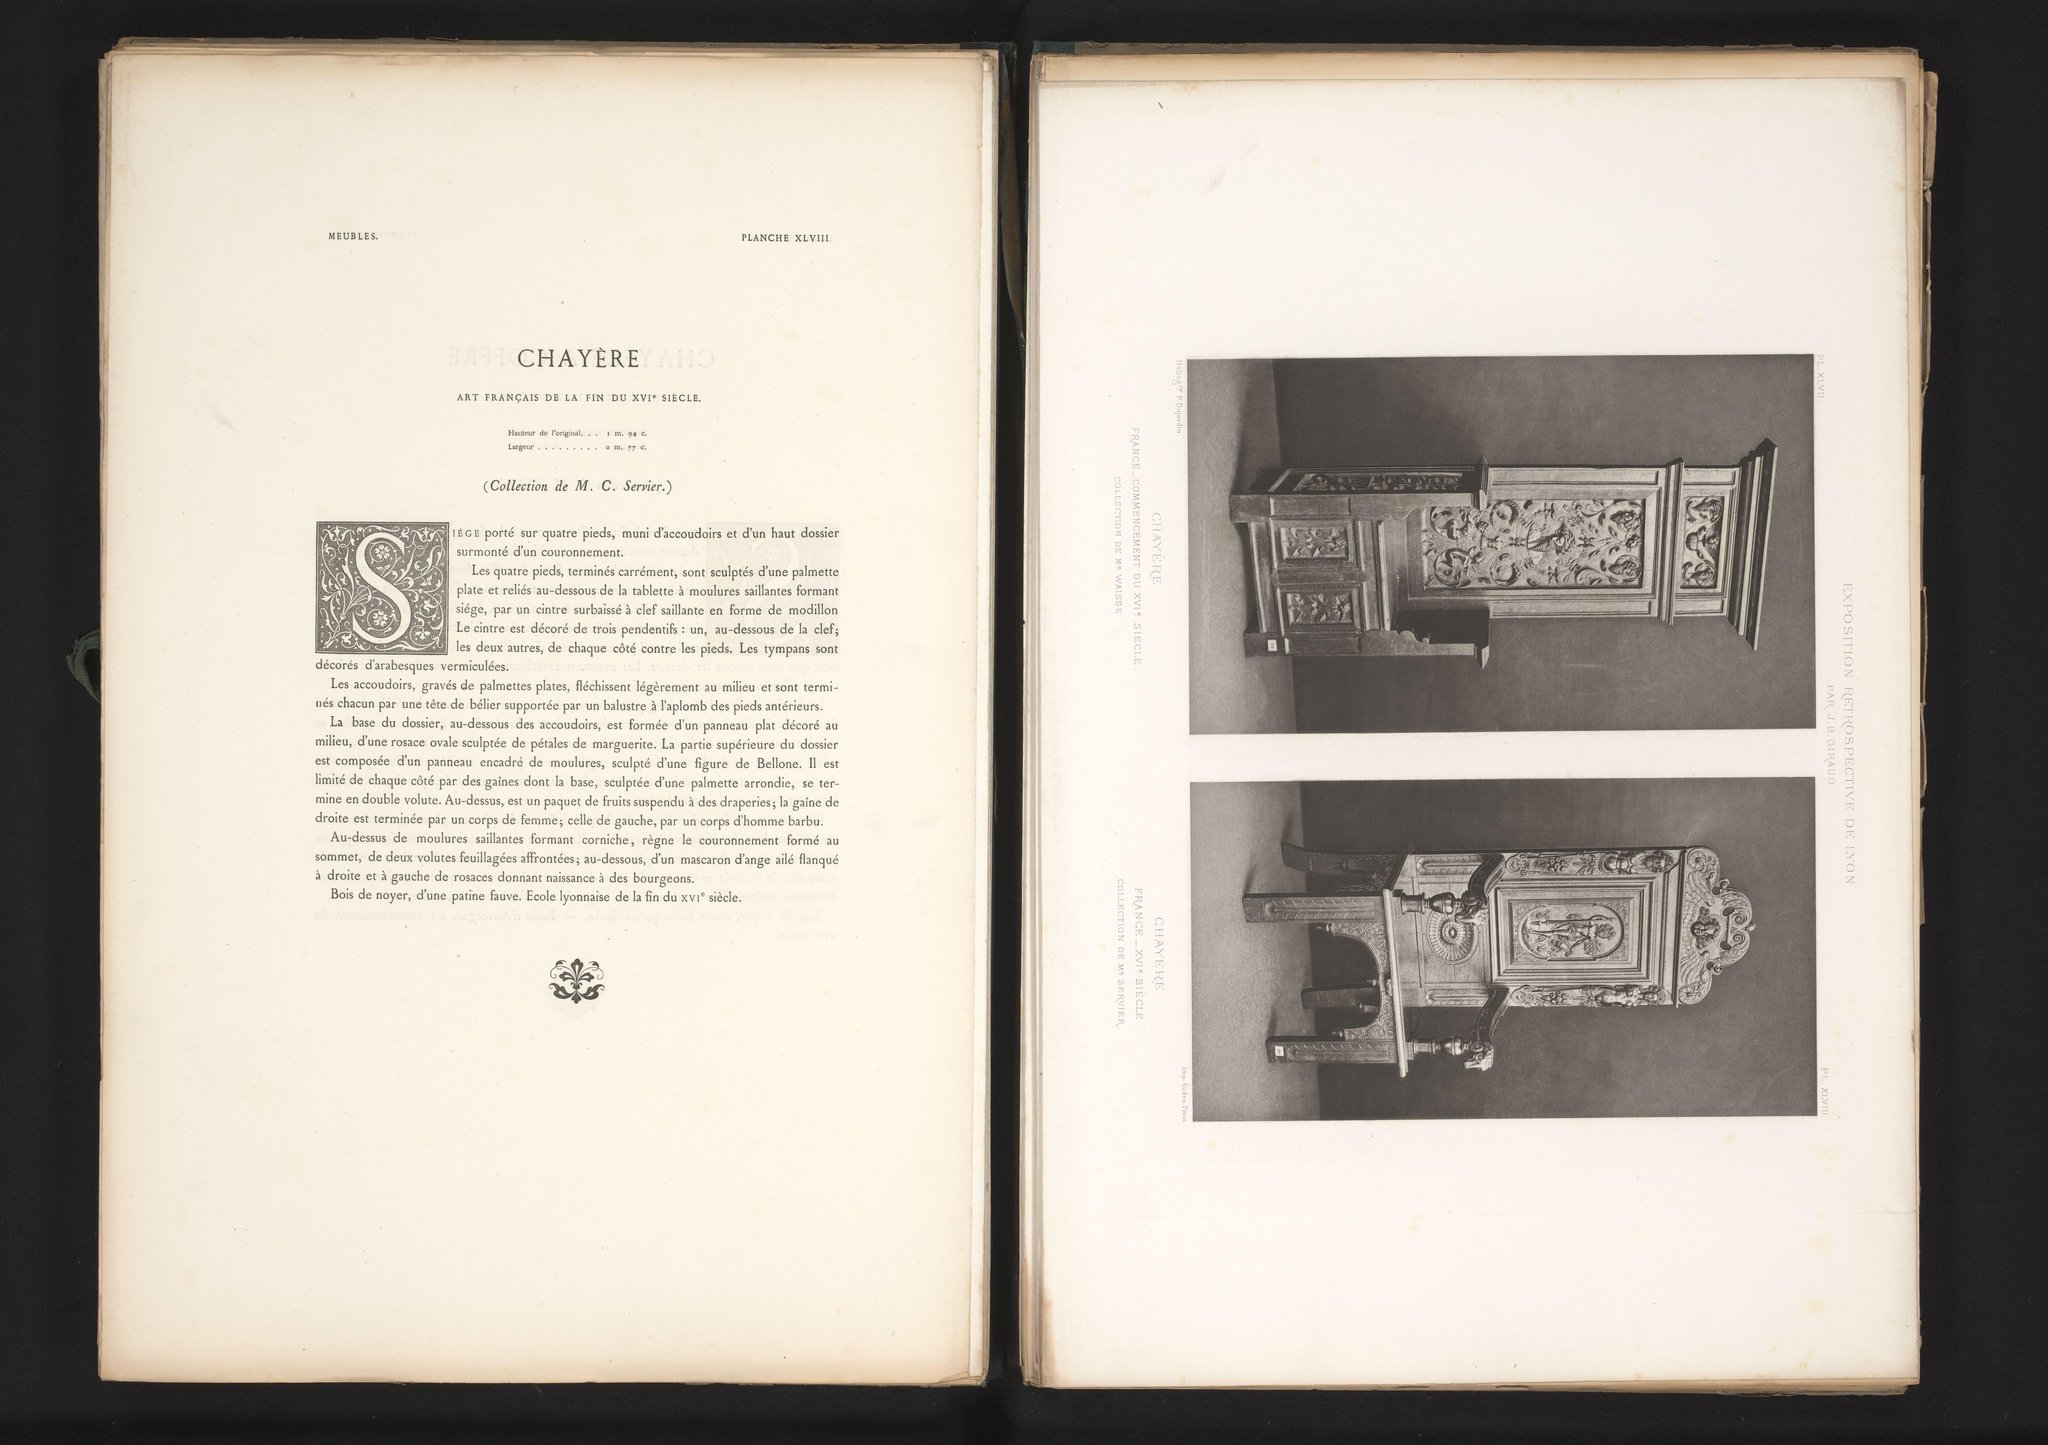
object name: photomechanical print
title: Twee 16de-eeuwse Franse zetels van hout, op de Exposition Rétrospective van 1877 in Lyon, Frankrijk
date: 1877-1878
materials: paper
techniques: photoaquatint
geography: paris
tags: chair (+ wood and other phytogenic material), lyon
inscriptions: inscription: ‘EXPOSITION RÉTROSPECTIVE DE LYON/ PAR J. B. GIRAUD.’, inscription: ‘CHAYÈRE/ FRANCE_COMMENCEMENT DU XVIe SIÈCLE/ COLLECTION DE Mr WAISSE.’, inscription: ‘CHAYÈRE/ FRANCE_XVIe SIÈCLE/ COLLECTION DE Mr SERVIER.’, number: ‘PL. XLVII.’, number: ‘PL. XLVIII.’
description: Deze prenten maken deel uit van een omslag met 79 prenten op 54 bladen en 65 tekstbladen.